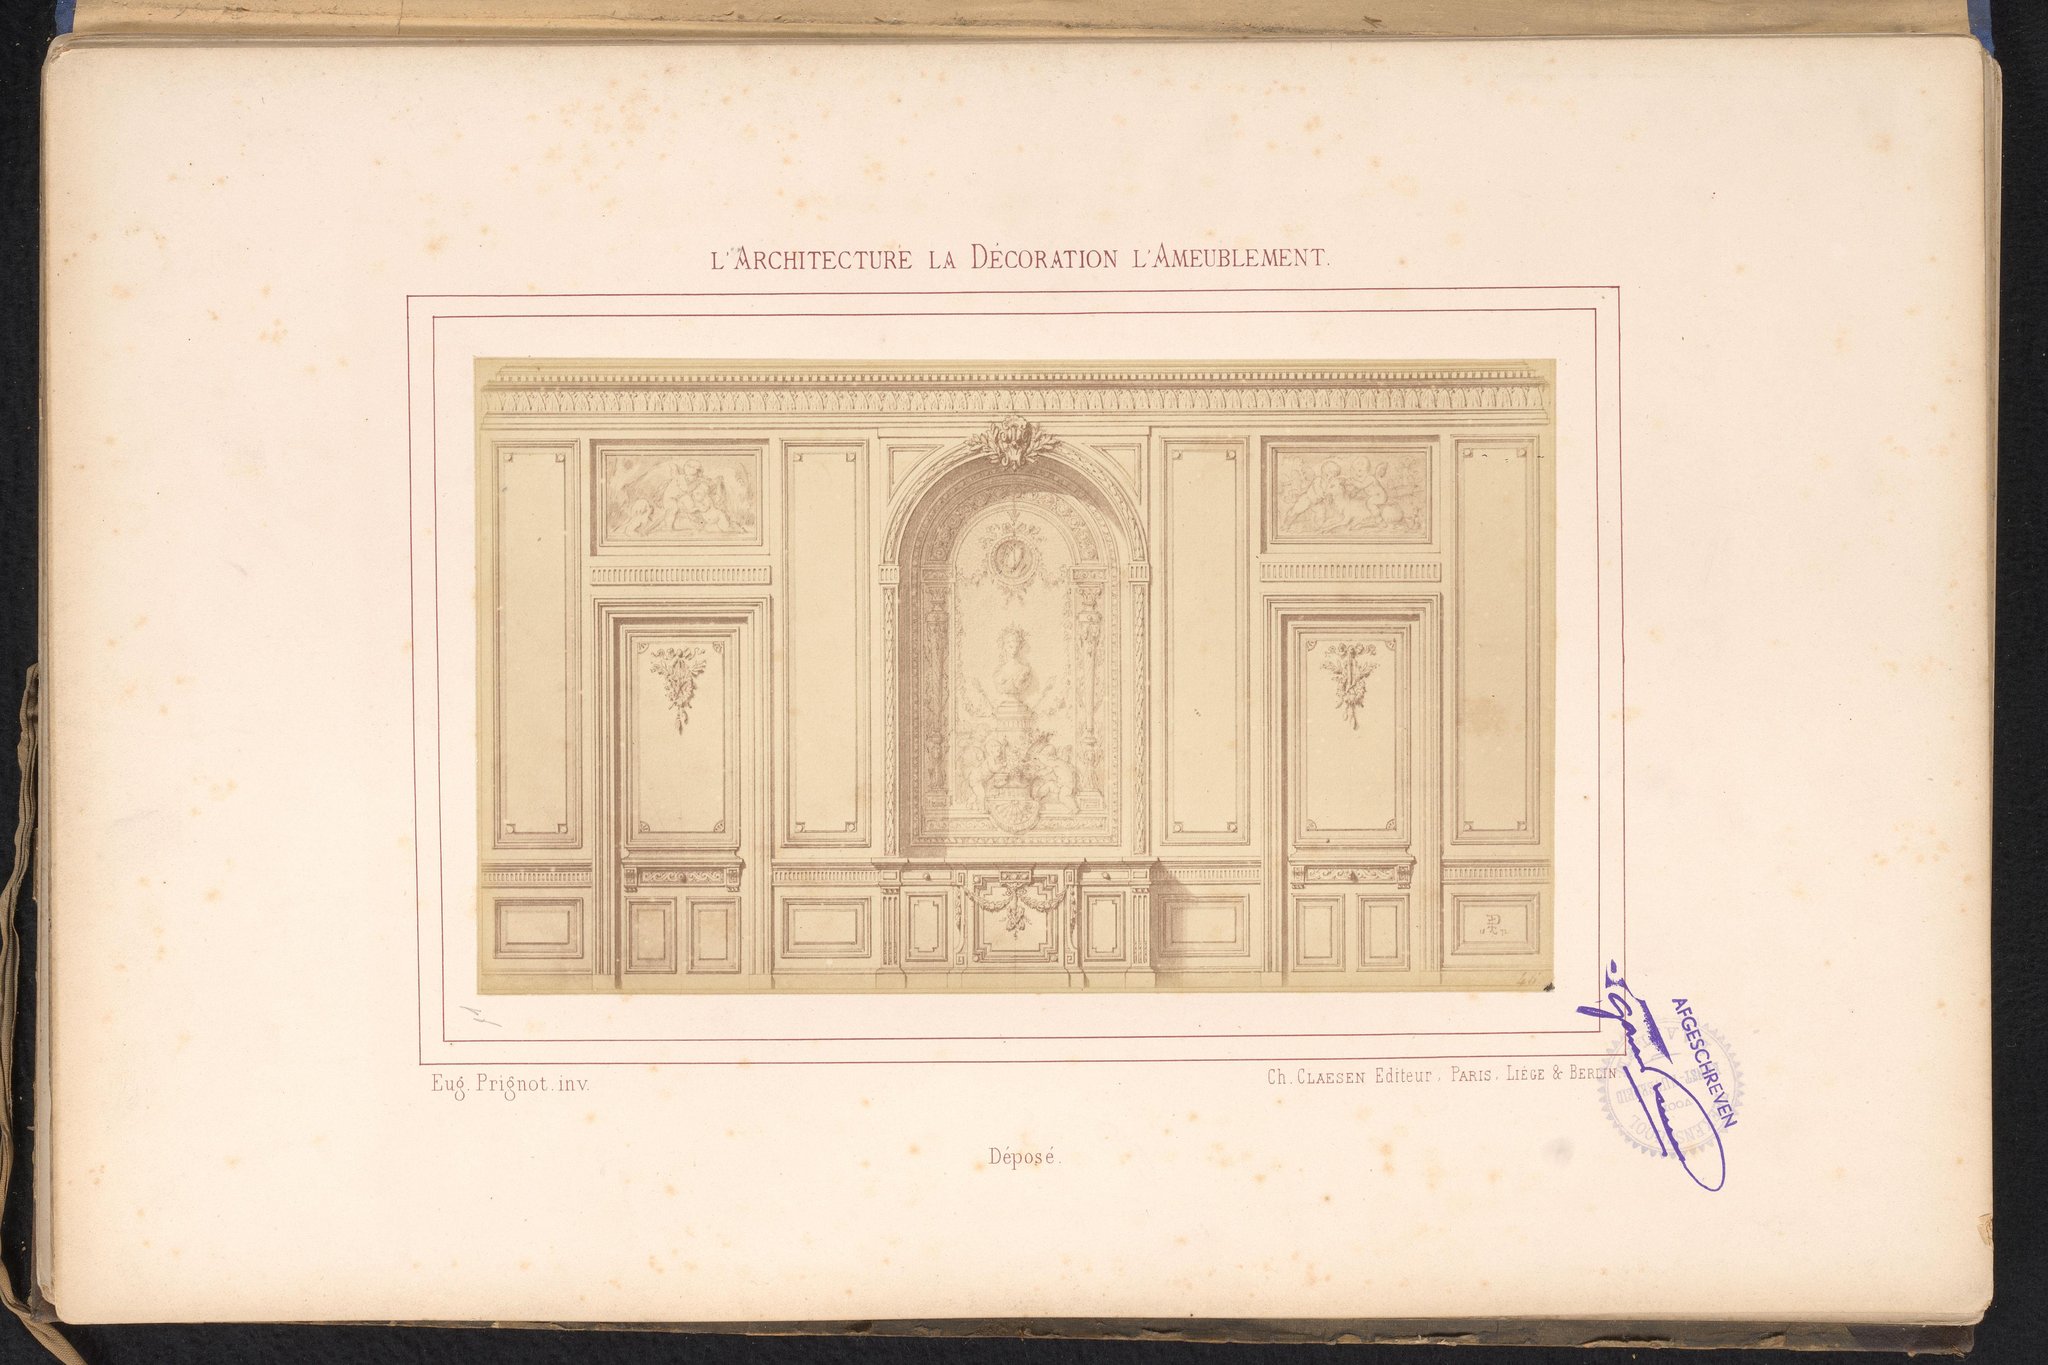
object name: photograph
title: L'Architecture la Décoration l'Ameublement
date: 1873-1880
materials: cardboard, paper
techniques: albumen print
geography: liège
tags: wall-covering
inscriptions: inscription: ‘Eug. Prignot. inv.’, stamp: ‘AFGESCHREVEN/ [...]’, stamp: ‘TEEKENSCHOOL/ VOOR/ KUNST-NIJVERHEID/ HAARLEM’, number: ‘46’, inscription: ‘Déposé’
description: Deze foto maakt deel uit van een omslag met 61 foto's op 61 bladen.